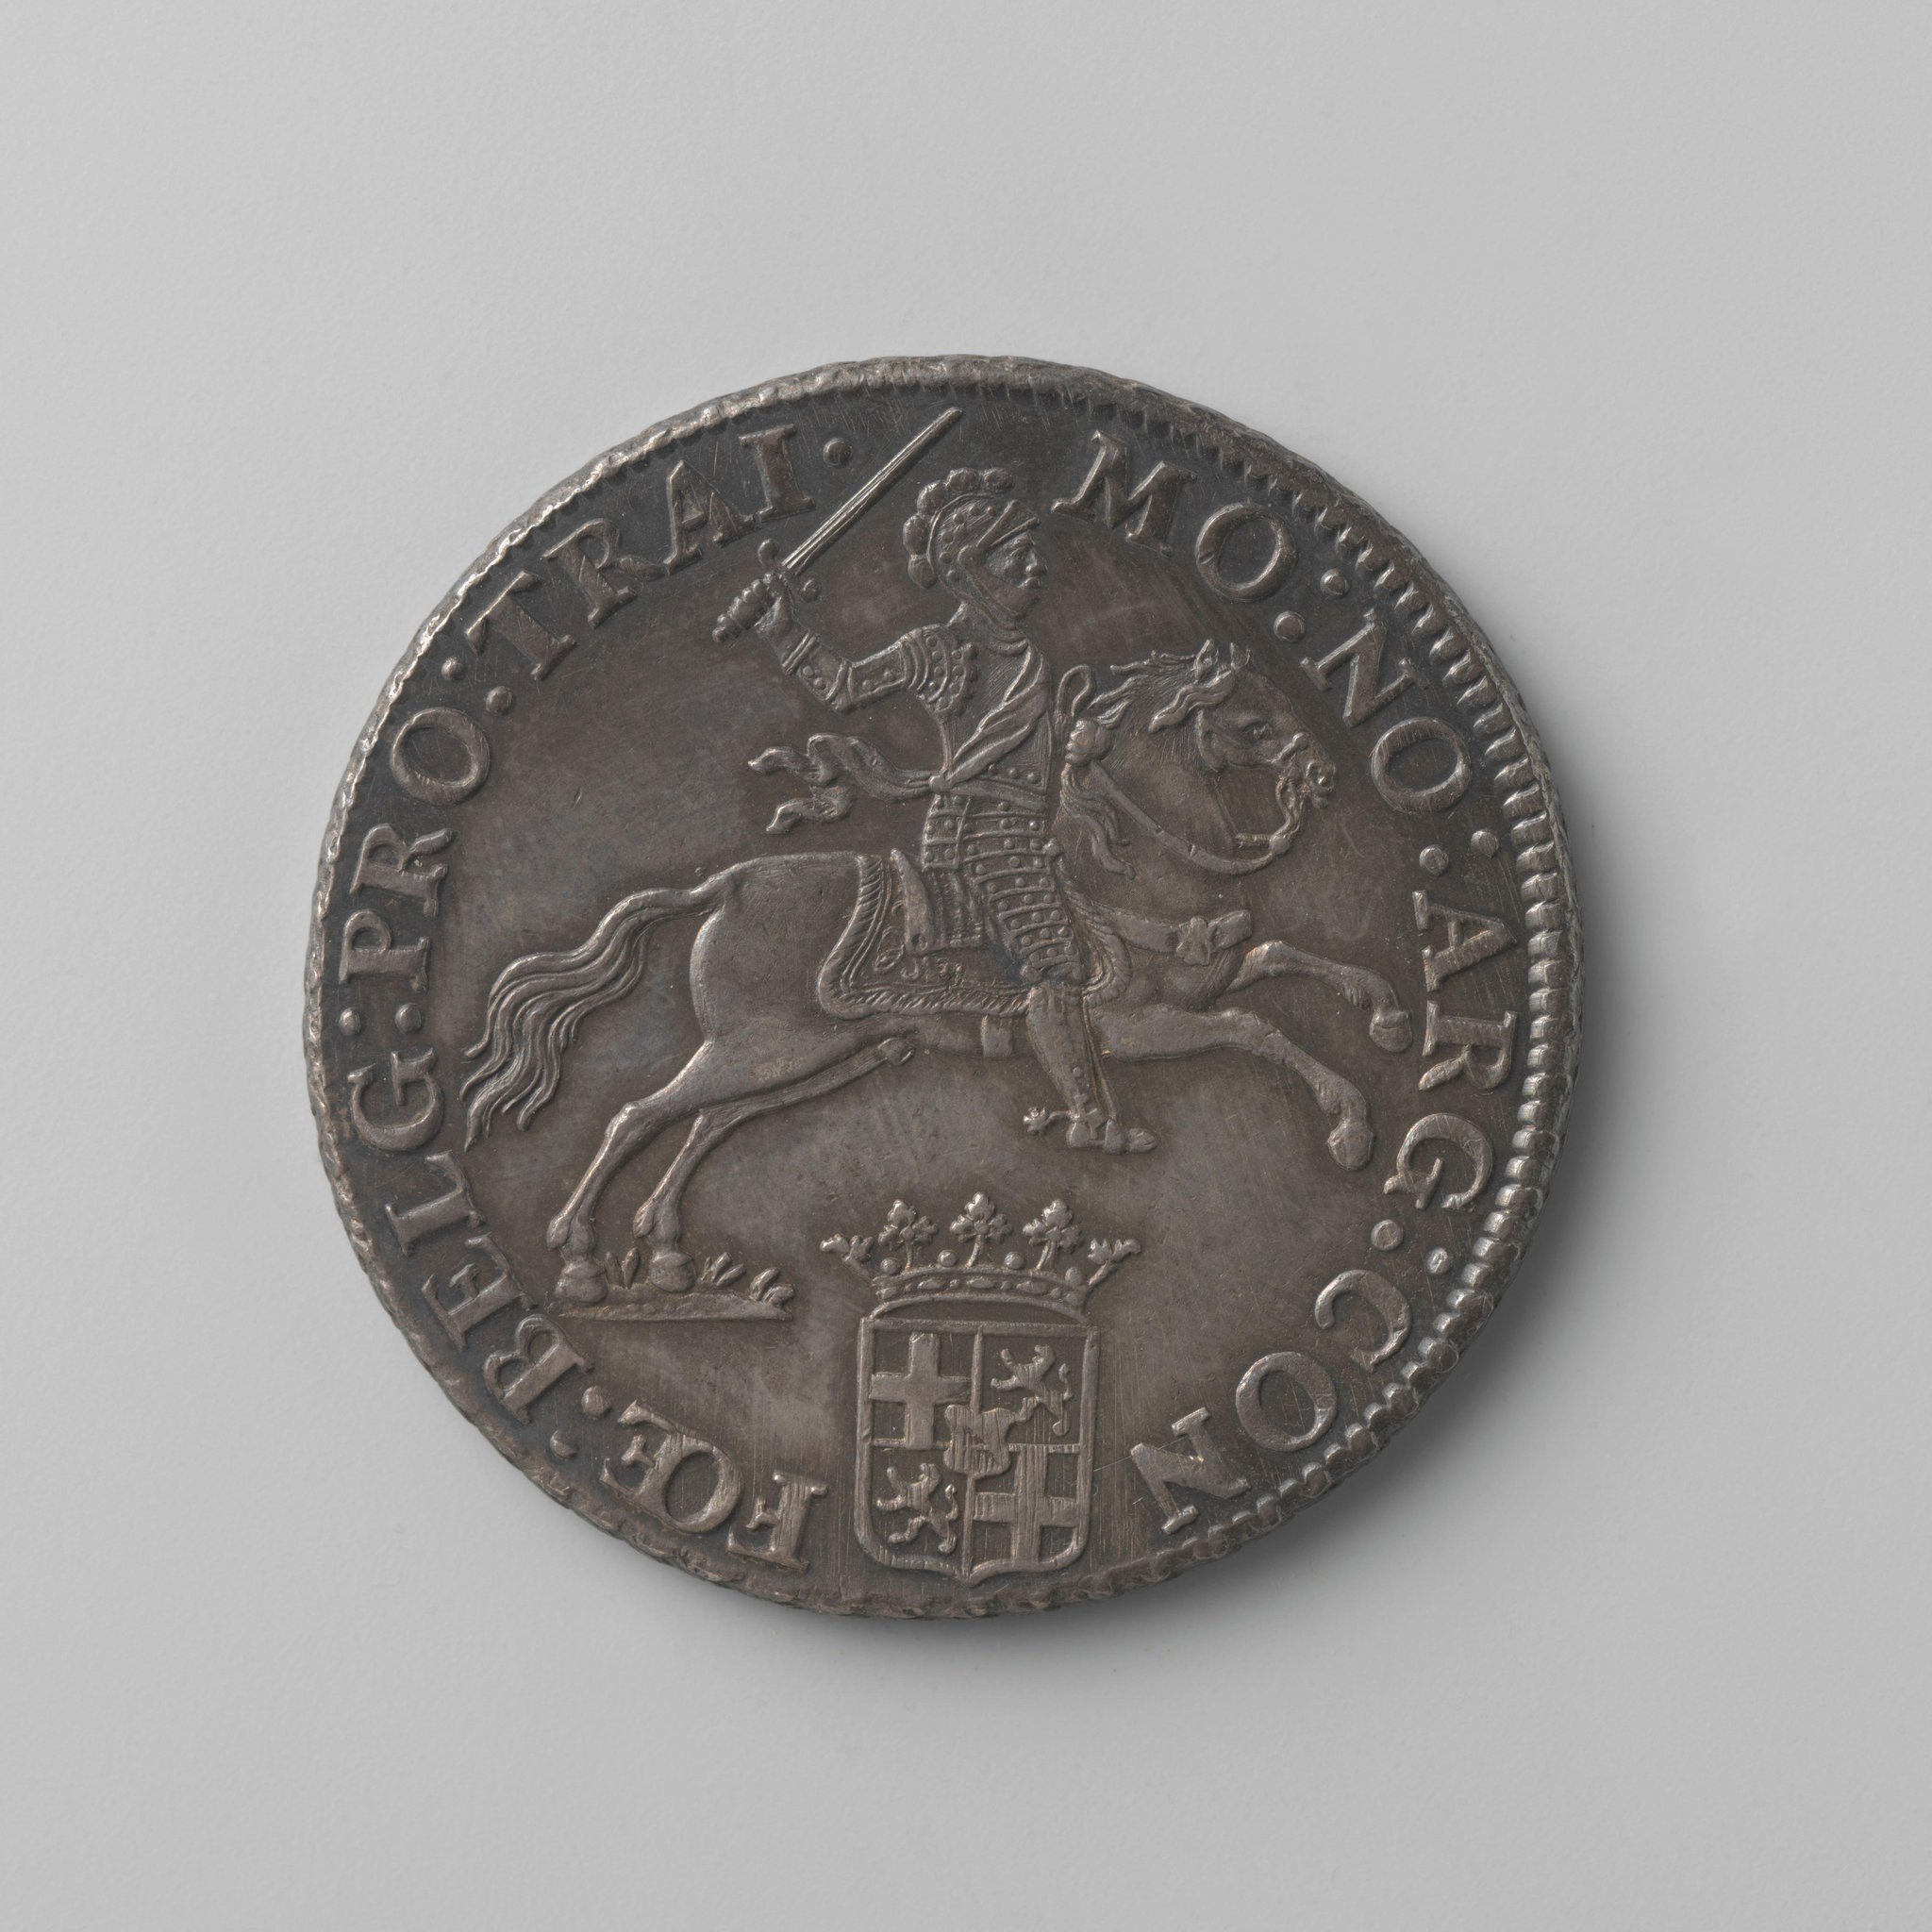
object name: coin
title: Utrecht, zilveren rijder, 1764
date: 1764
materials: silver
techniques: striking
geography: utrecht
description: Zilveren munt. Voorzijde: ridder te paard naar rechts met in rechterhand zwaard. Onder paard gekroond wapenschild van Utrecht. Keerzijde: door twee gekroonde leeuwen gehouden generaliteitswapenschild. Daaronder in cartouche jaartal. Bloemrand.